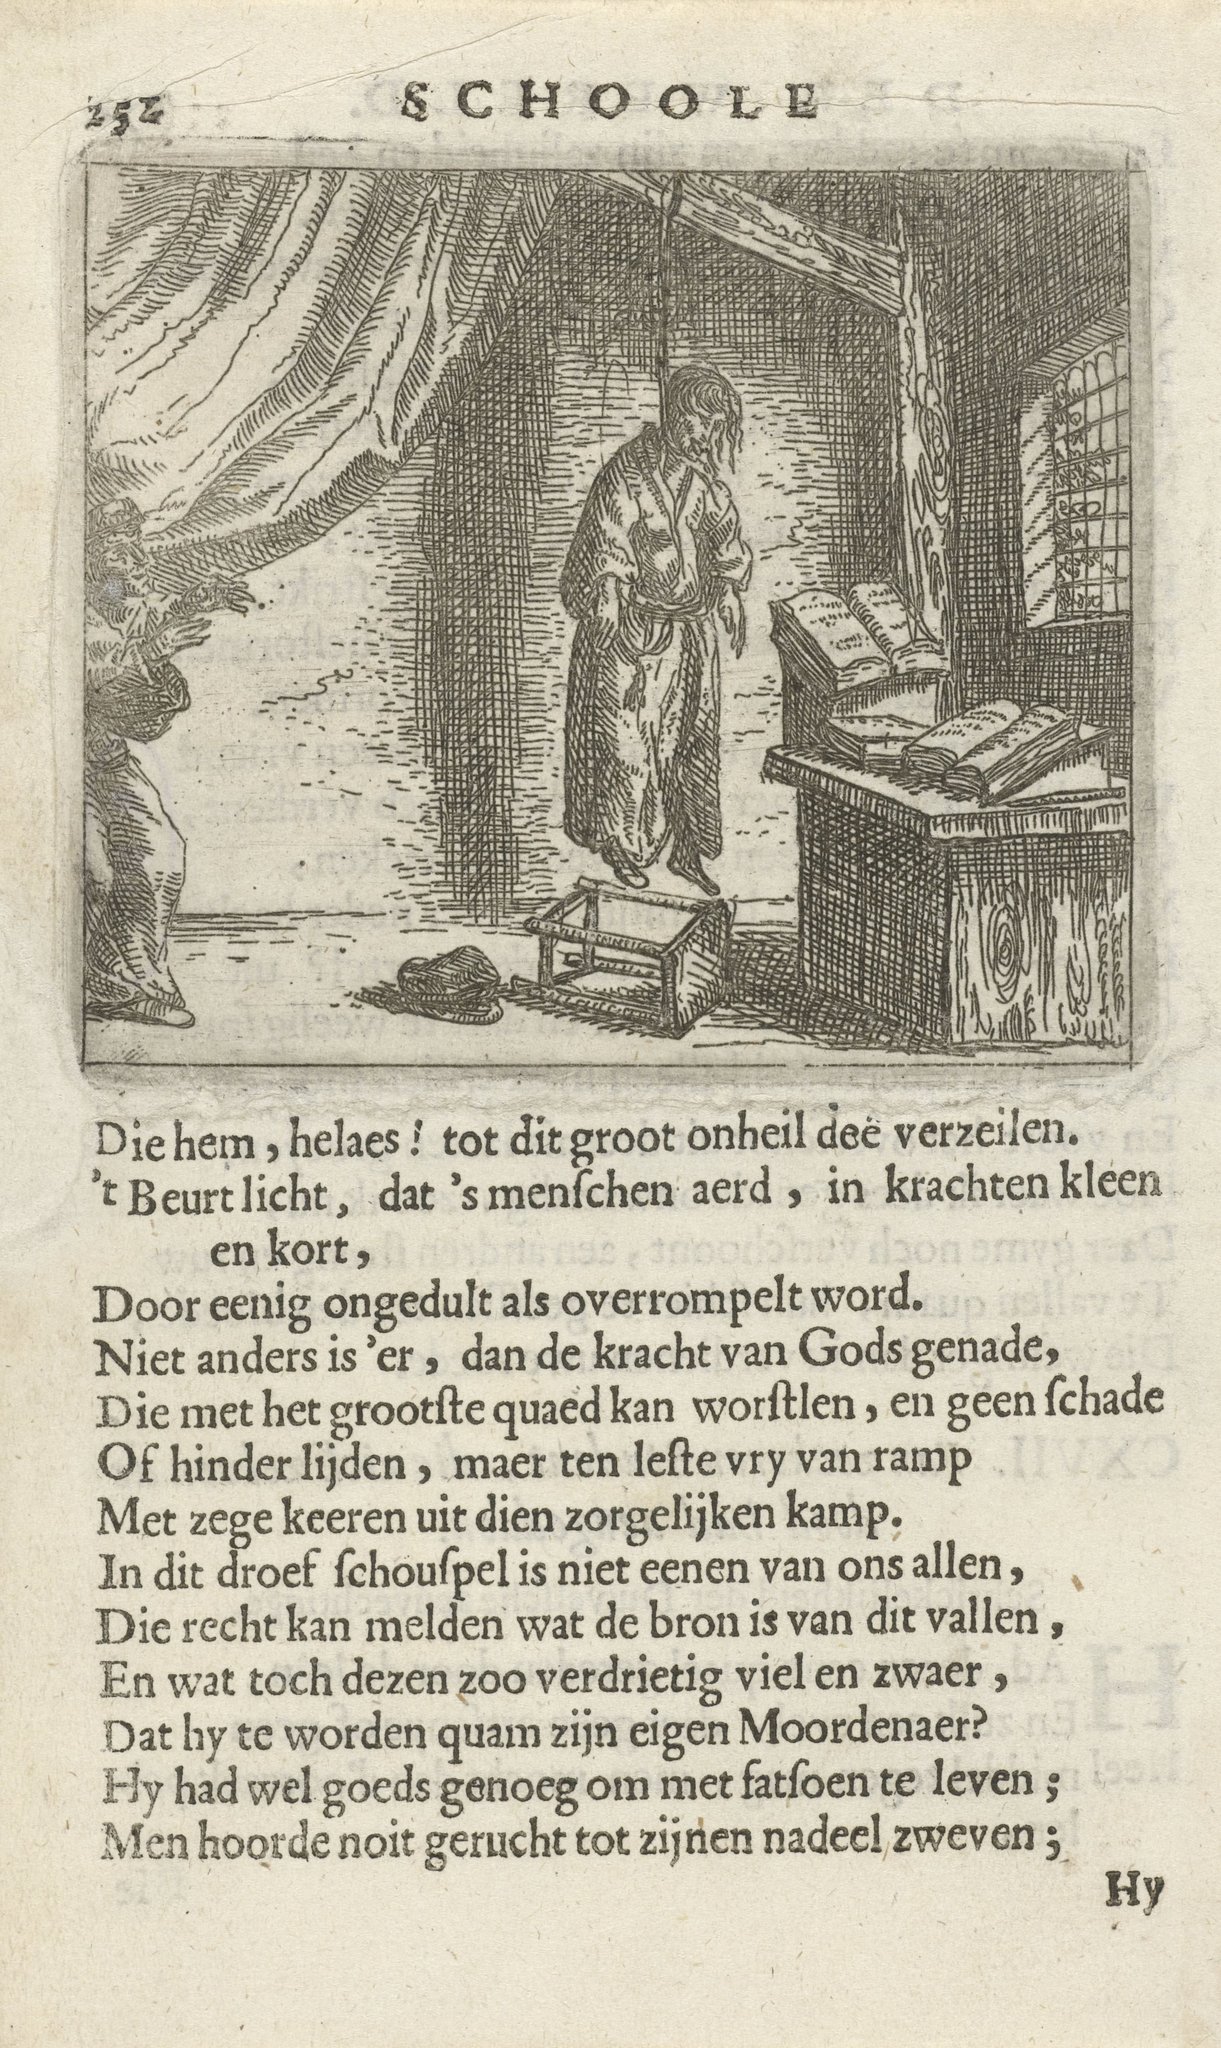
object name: book illustration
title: Gehangene in een studeervertrek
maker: arnold houbraken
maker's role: draughtsman, painter, print maker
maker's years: 1660-1719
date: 1682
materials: paper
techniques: etching, letterpress printing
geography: northern netherlands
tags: seeking death, suicide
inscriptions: collector's mark: Lugt 2228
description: Prent uit: Joseph Hall, [bewerkt door] François van Hoogstraeten, De schoole der wereld, geopent in CXL. vliegende bedenkingen op veelerhande voorvallende gezichten en zaeken. Dordrecht: François van Hoogstraeten, 1682. En in herdrukken in 1687 en 1725.